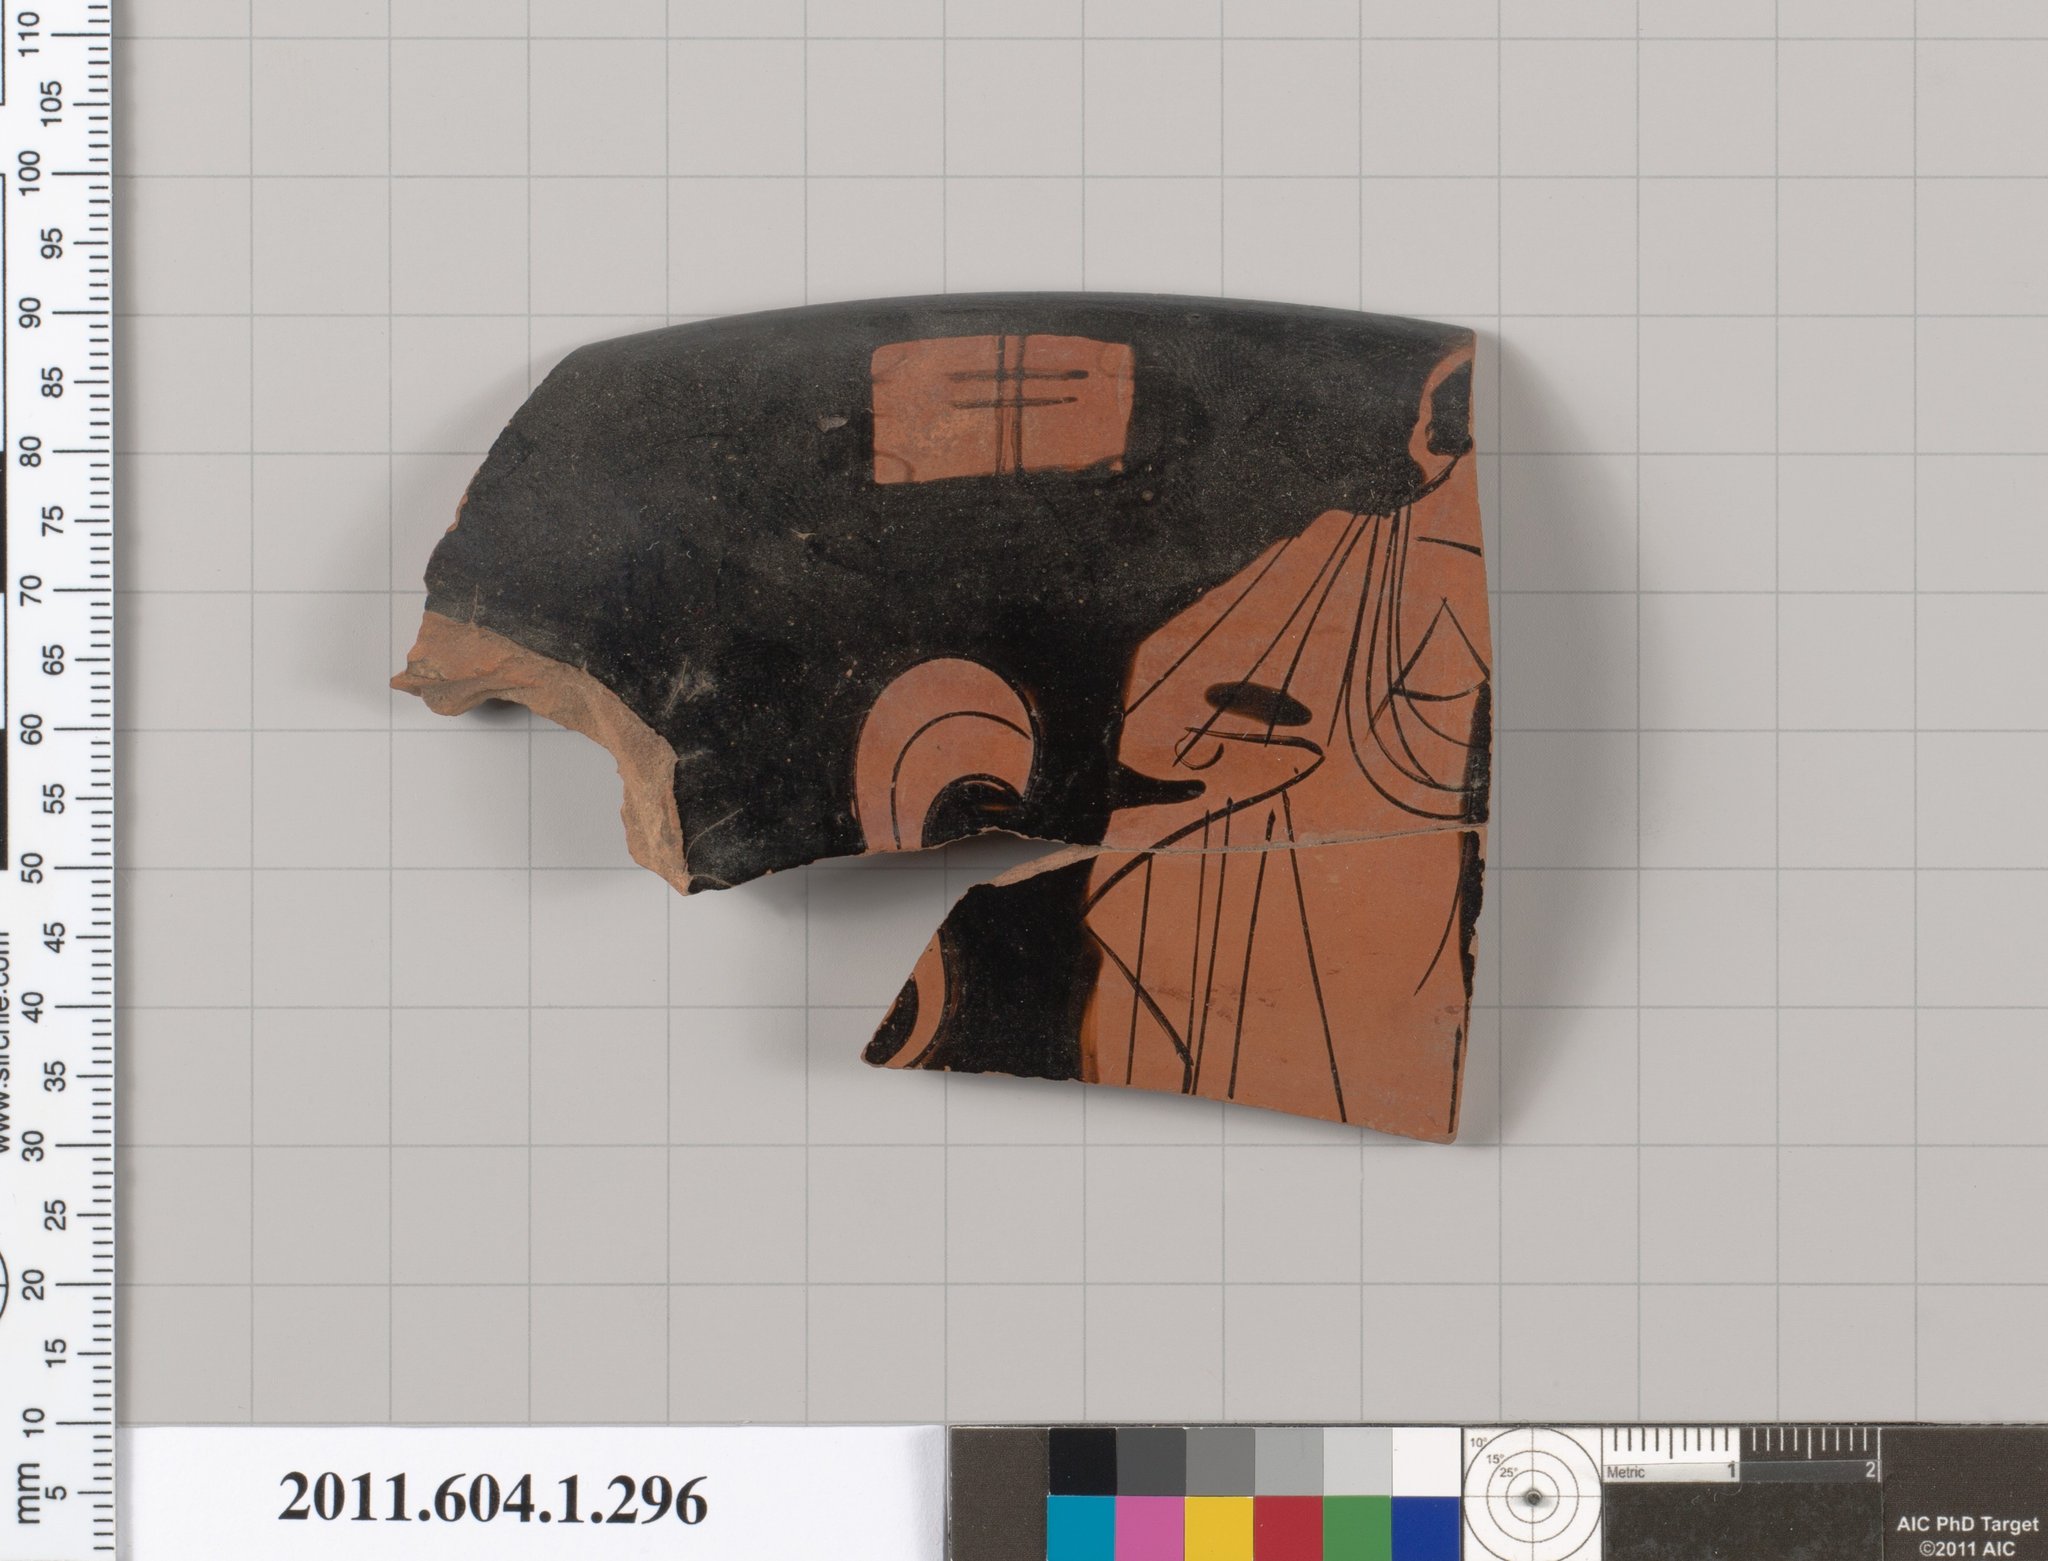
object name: kylix fragment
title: Terracotta rim fragment of a kylix (drinking cup)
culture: greek, attic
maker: painter z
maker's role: artist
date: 475-451 BCE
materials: terracotta